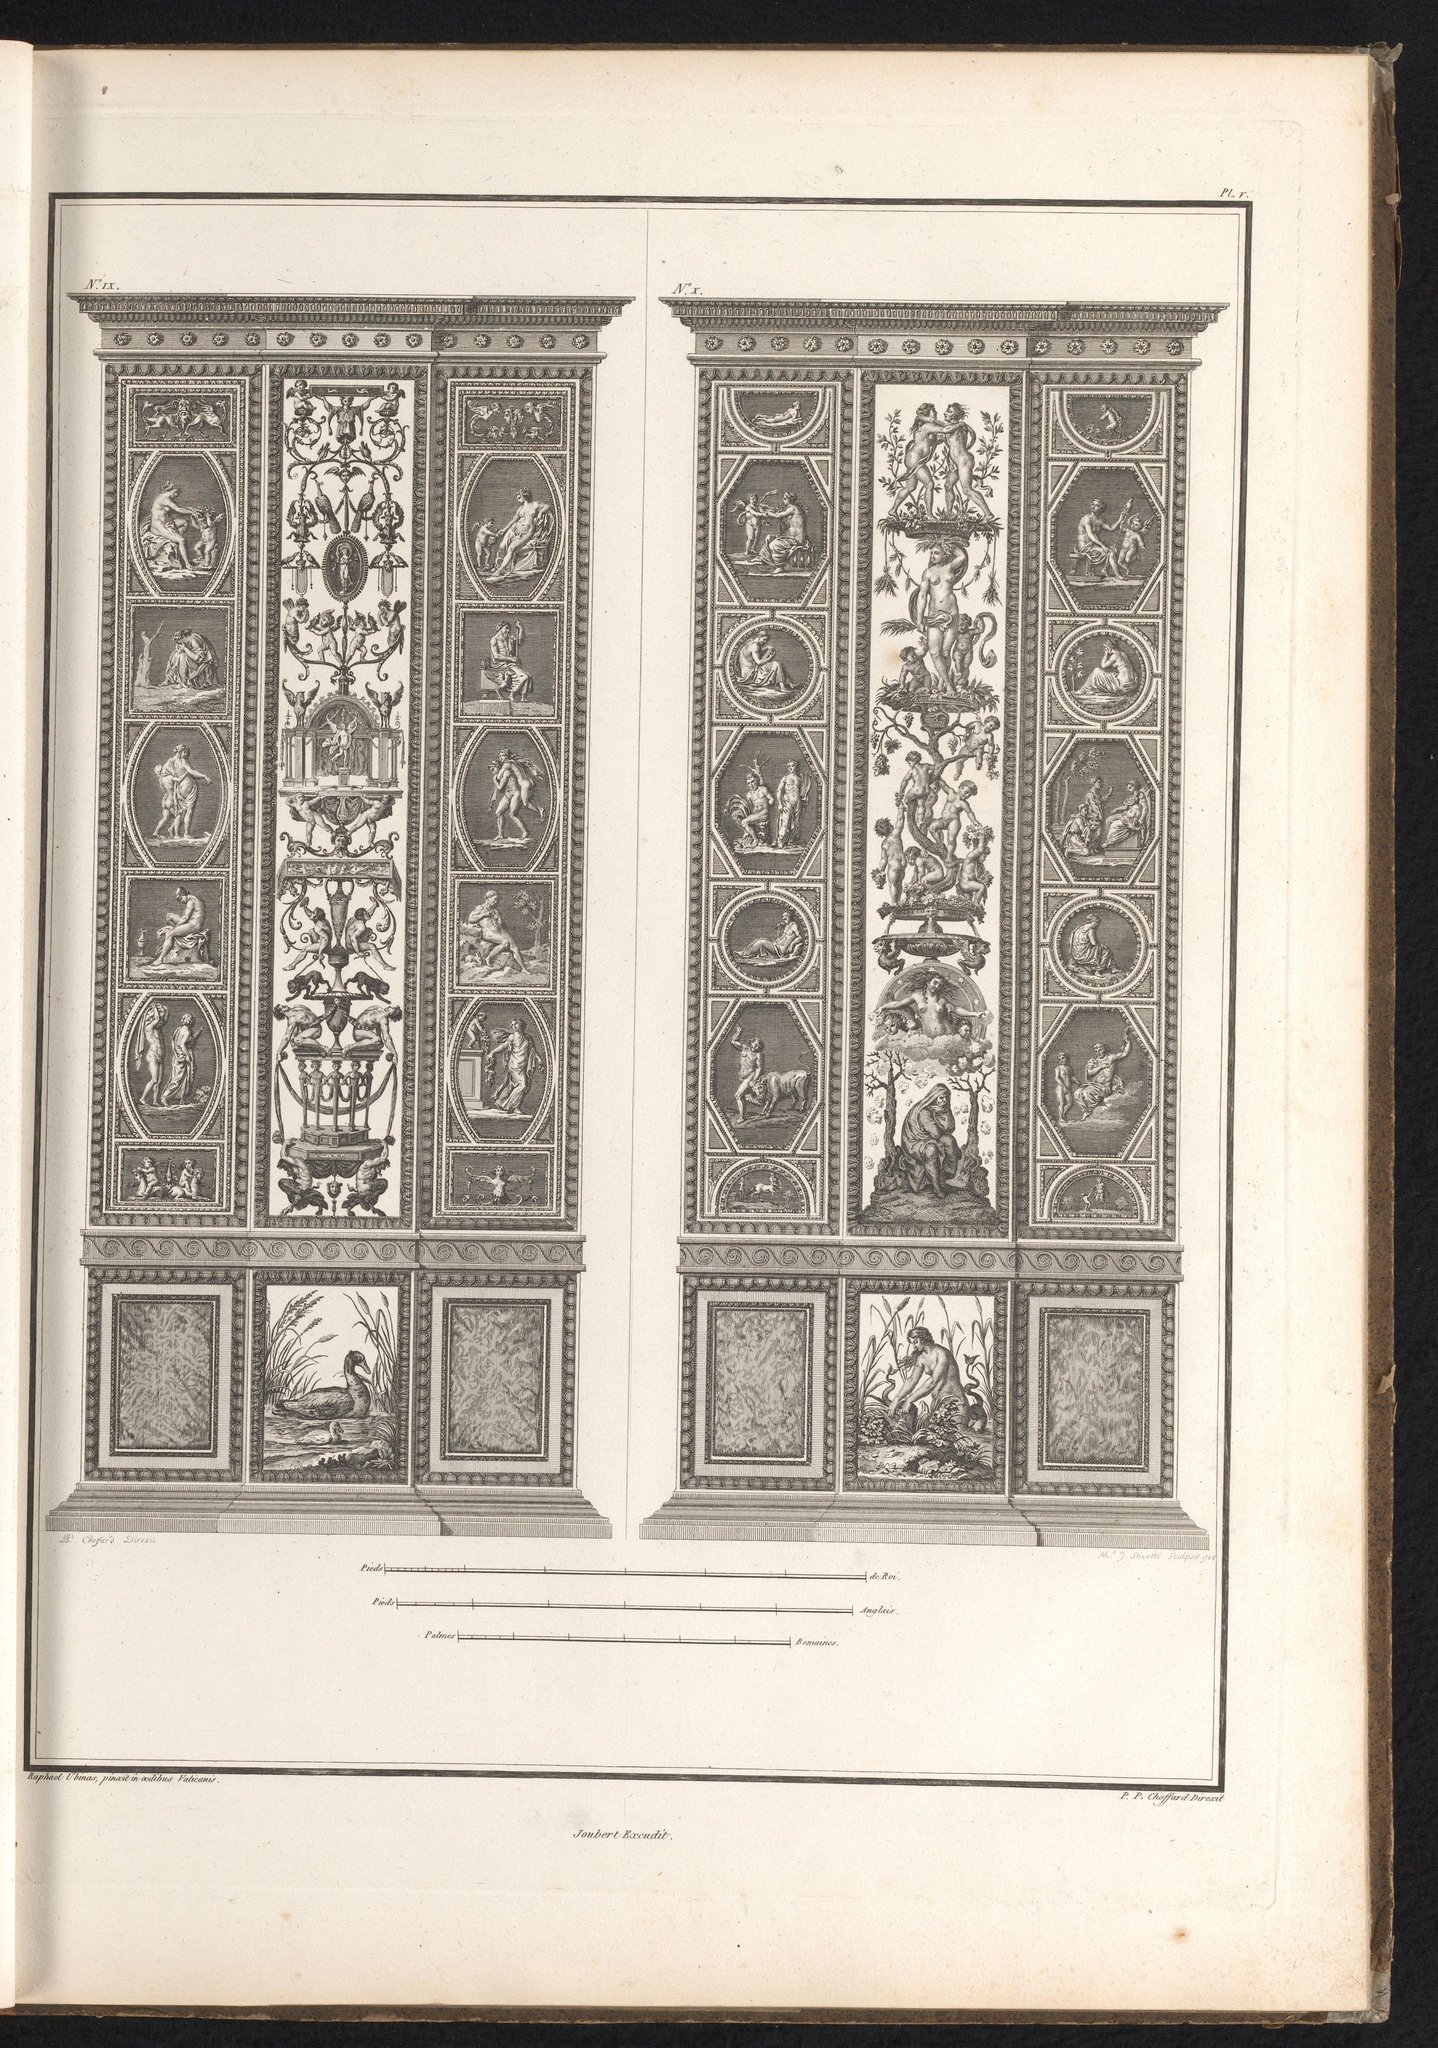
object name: ornament print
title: Verzameling van arabesken, met de Vaticaanse loggia's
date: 1788-1802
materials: paper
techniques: engraving, etching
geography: paris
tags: panelling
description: Doordat dit album bestaat uit meerdere, deels eerder uitgegeven prentreeksen, is de datering niet consequent. Het geheel is op de titelpagina gedateerd op 1802. Deze tweede reeks over de Loggia van Rafaël is wisselend gedateerd tussen 1785 en 1790. Aangezien onduidelijk is wanneer de prenten in deze vorm precies uitgegeven zijn, worden beide data gehanteerd: zowel 1802 als publicatiedatum, en de eerdere datum zoals vermeld op de prent (dan wel 1785 indien de prent ongedateerd is). De serietitel voor het gehele werk is "Recueil d'arabesques, contenant les loges du Vatican". De andere serietitel is de titel van de specifieke reeks binnen het geheel.